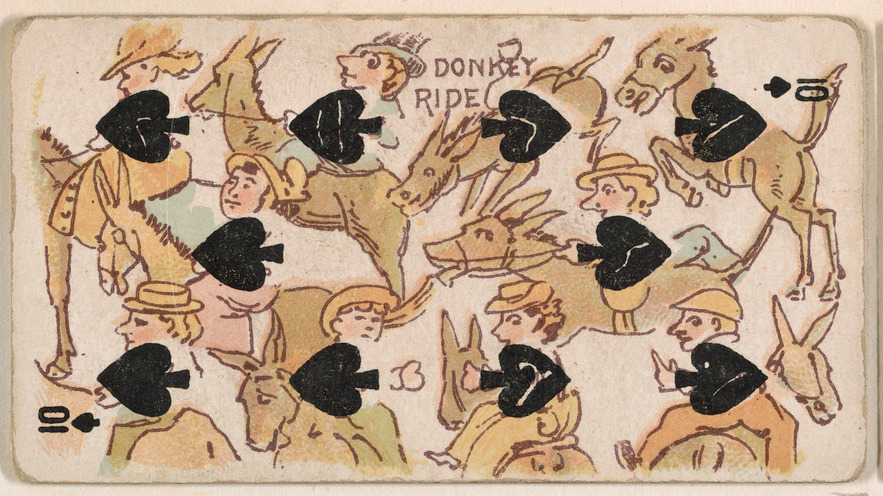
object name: print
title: Ten of Spades, Donkey Ride, from Harlequin Cards, 2nd Series (N220) issued by Kinney Bros.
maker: kinney brothers tobacco company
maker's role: publisher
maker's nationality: american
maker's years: 1869-2011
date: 1889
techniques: color lithograph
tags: playing cards,donkeys